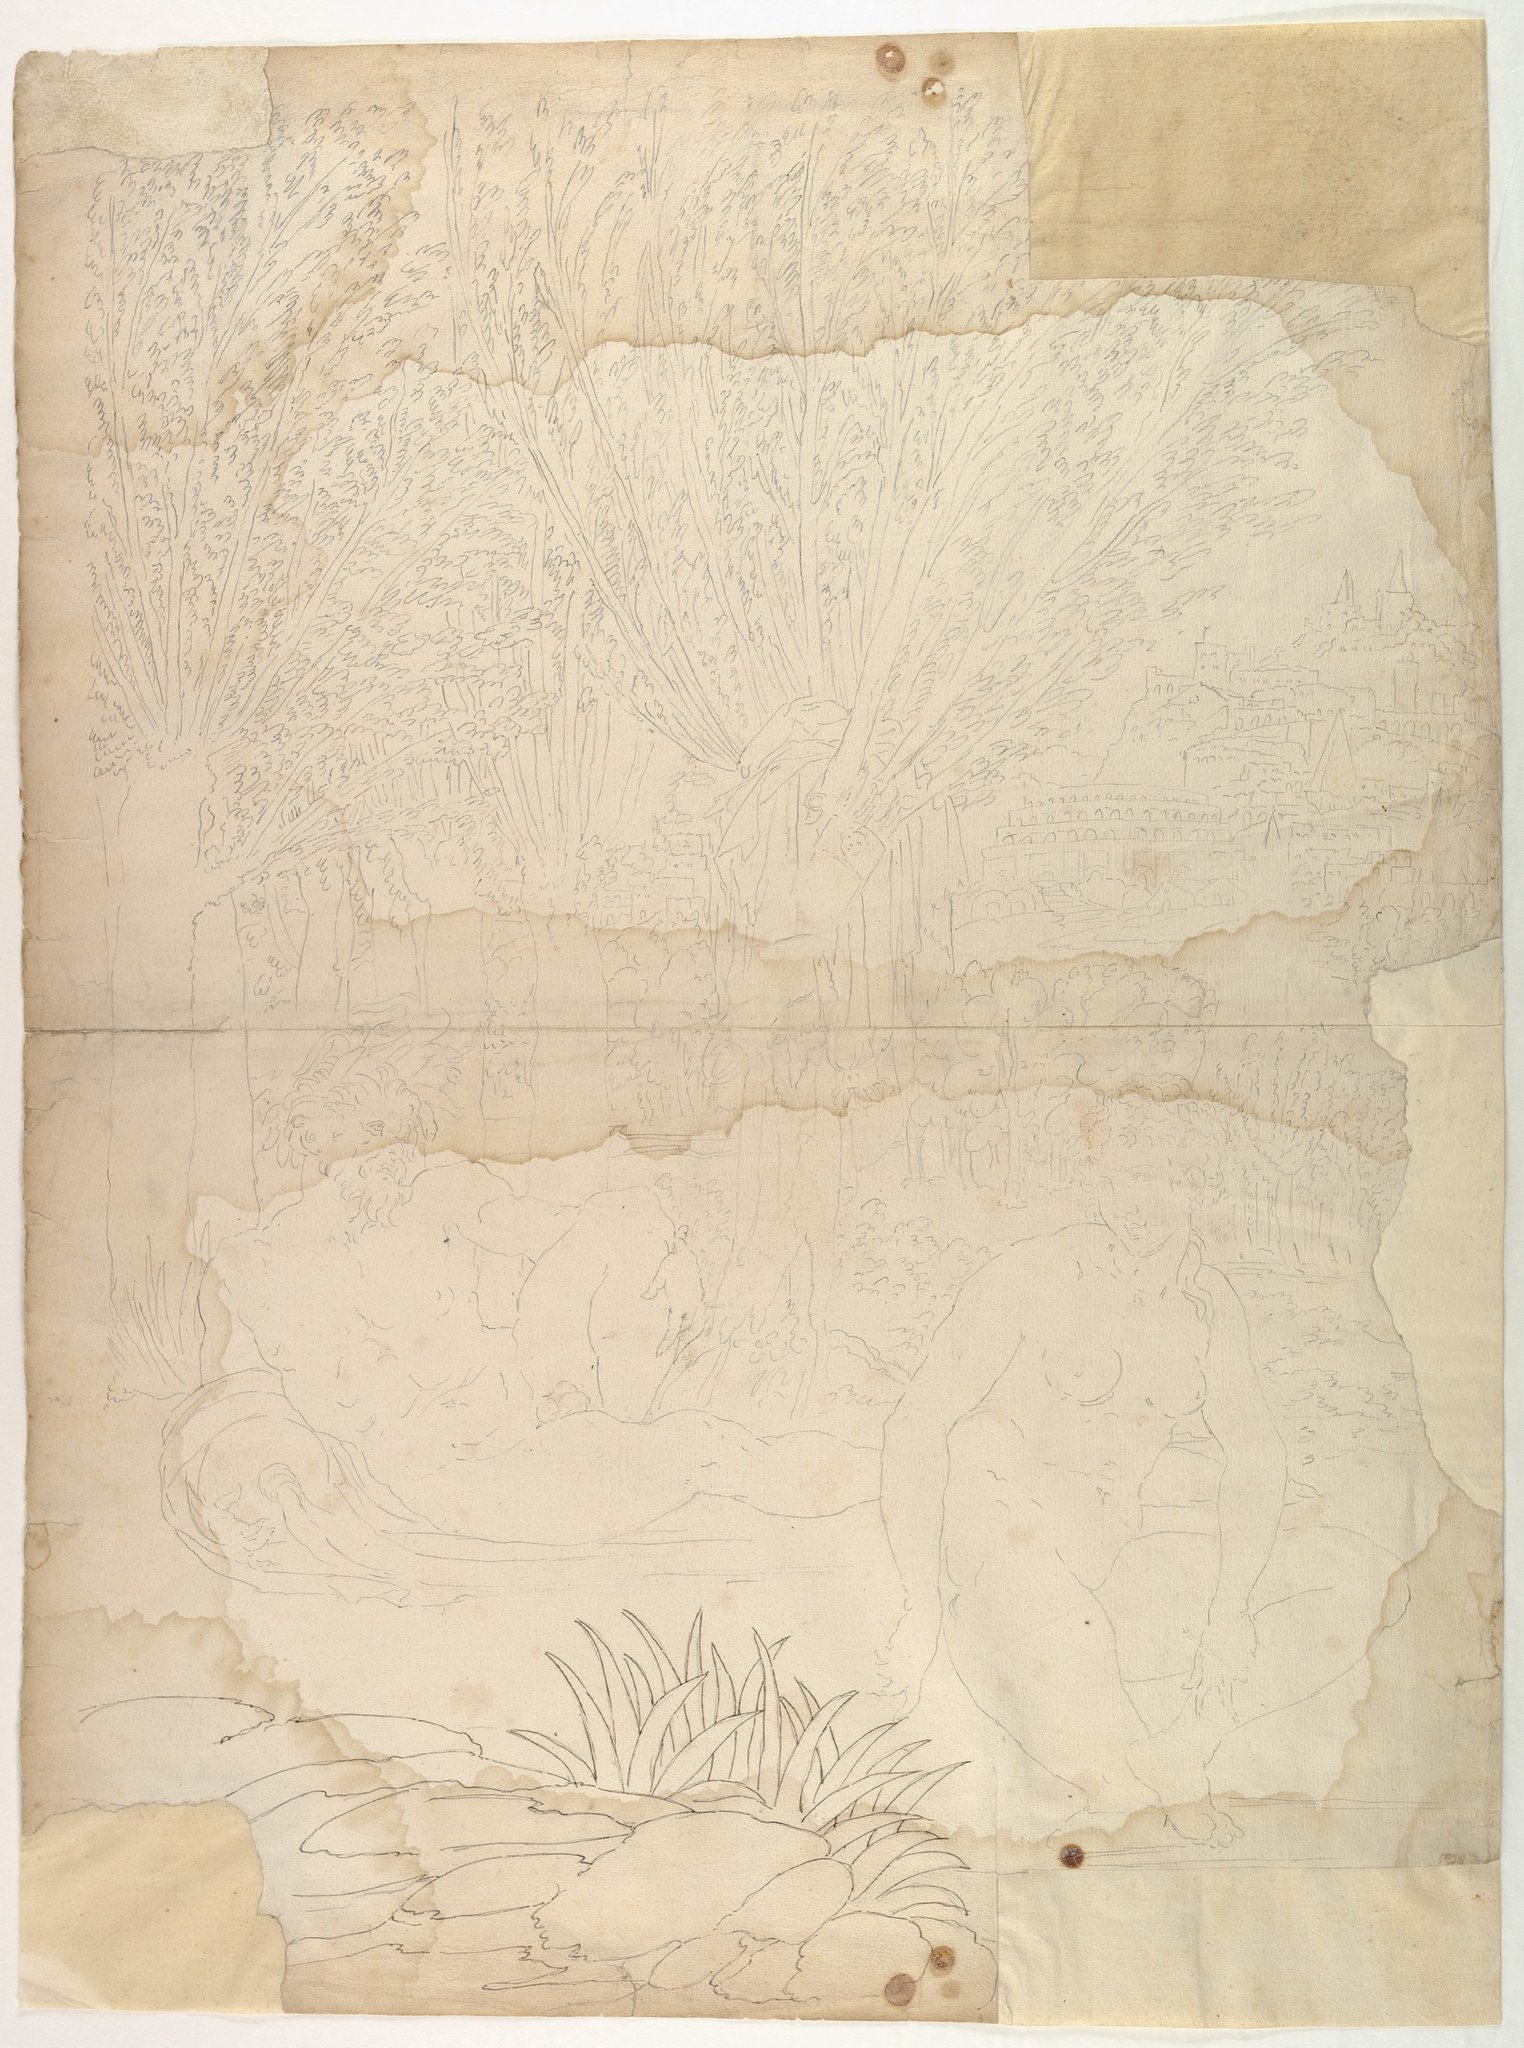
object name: drawing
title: Ornamental Drawing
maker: anonymous, french, 16th century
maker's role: artist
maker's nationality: french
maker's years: 1500-1600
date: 1501-1600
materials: ink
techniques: pen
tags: male nudes,female nudes,trees